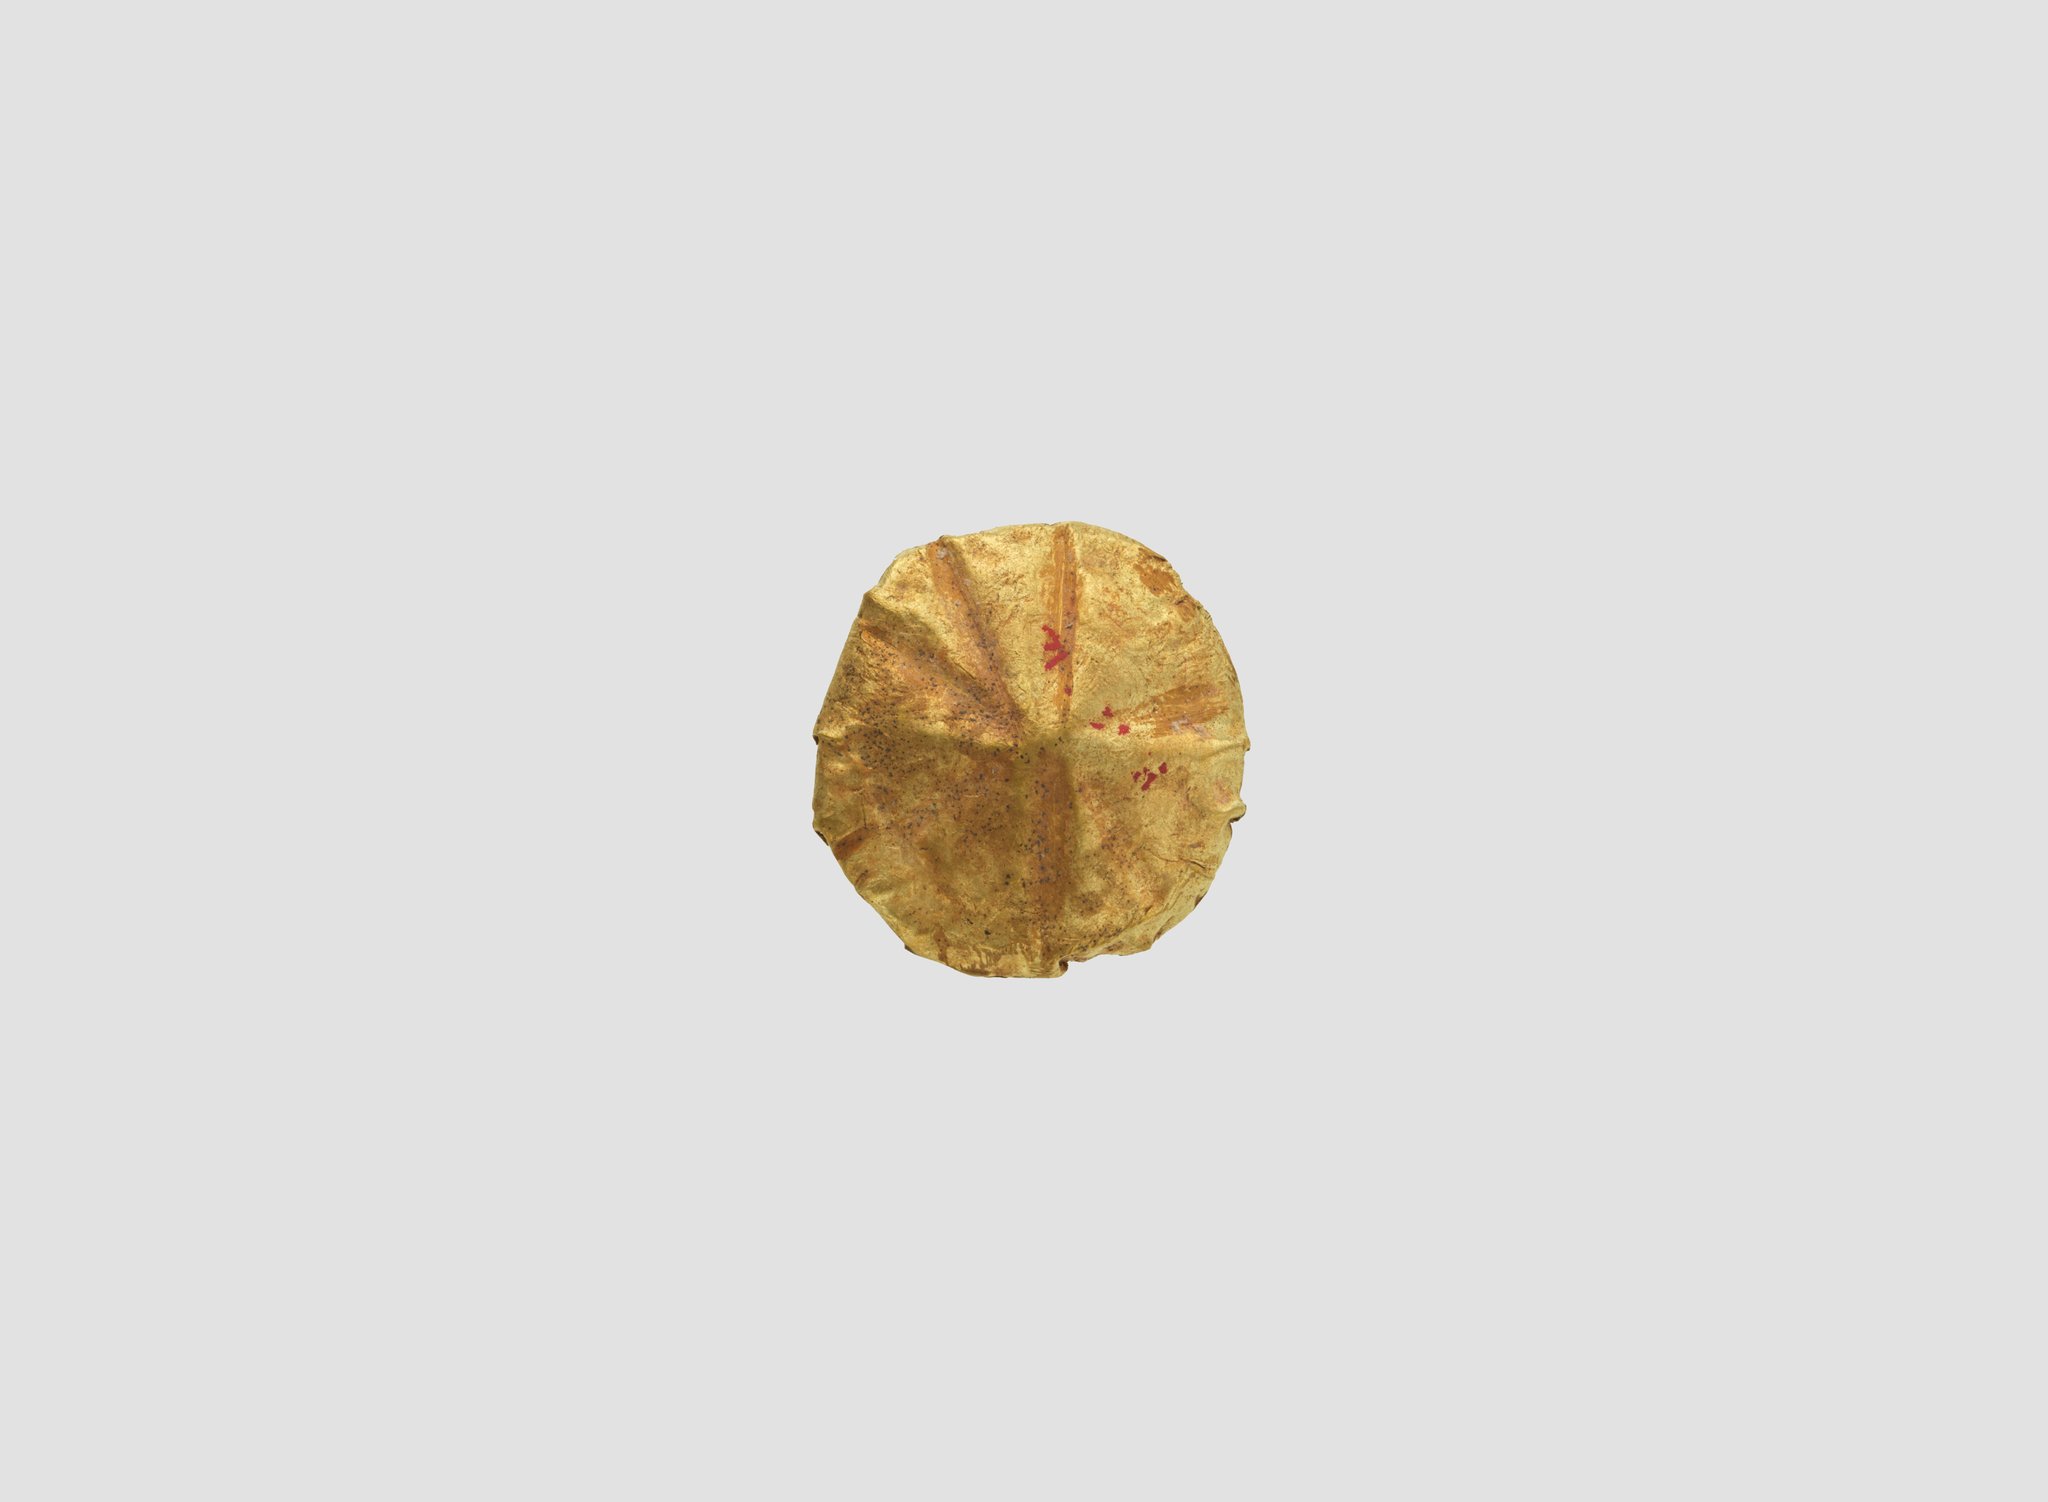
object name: button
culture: assyrian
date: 1000-668 BCE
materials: gold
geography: mesopotamia